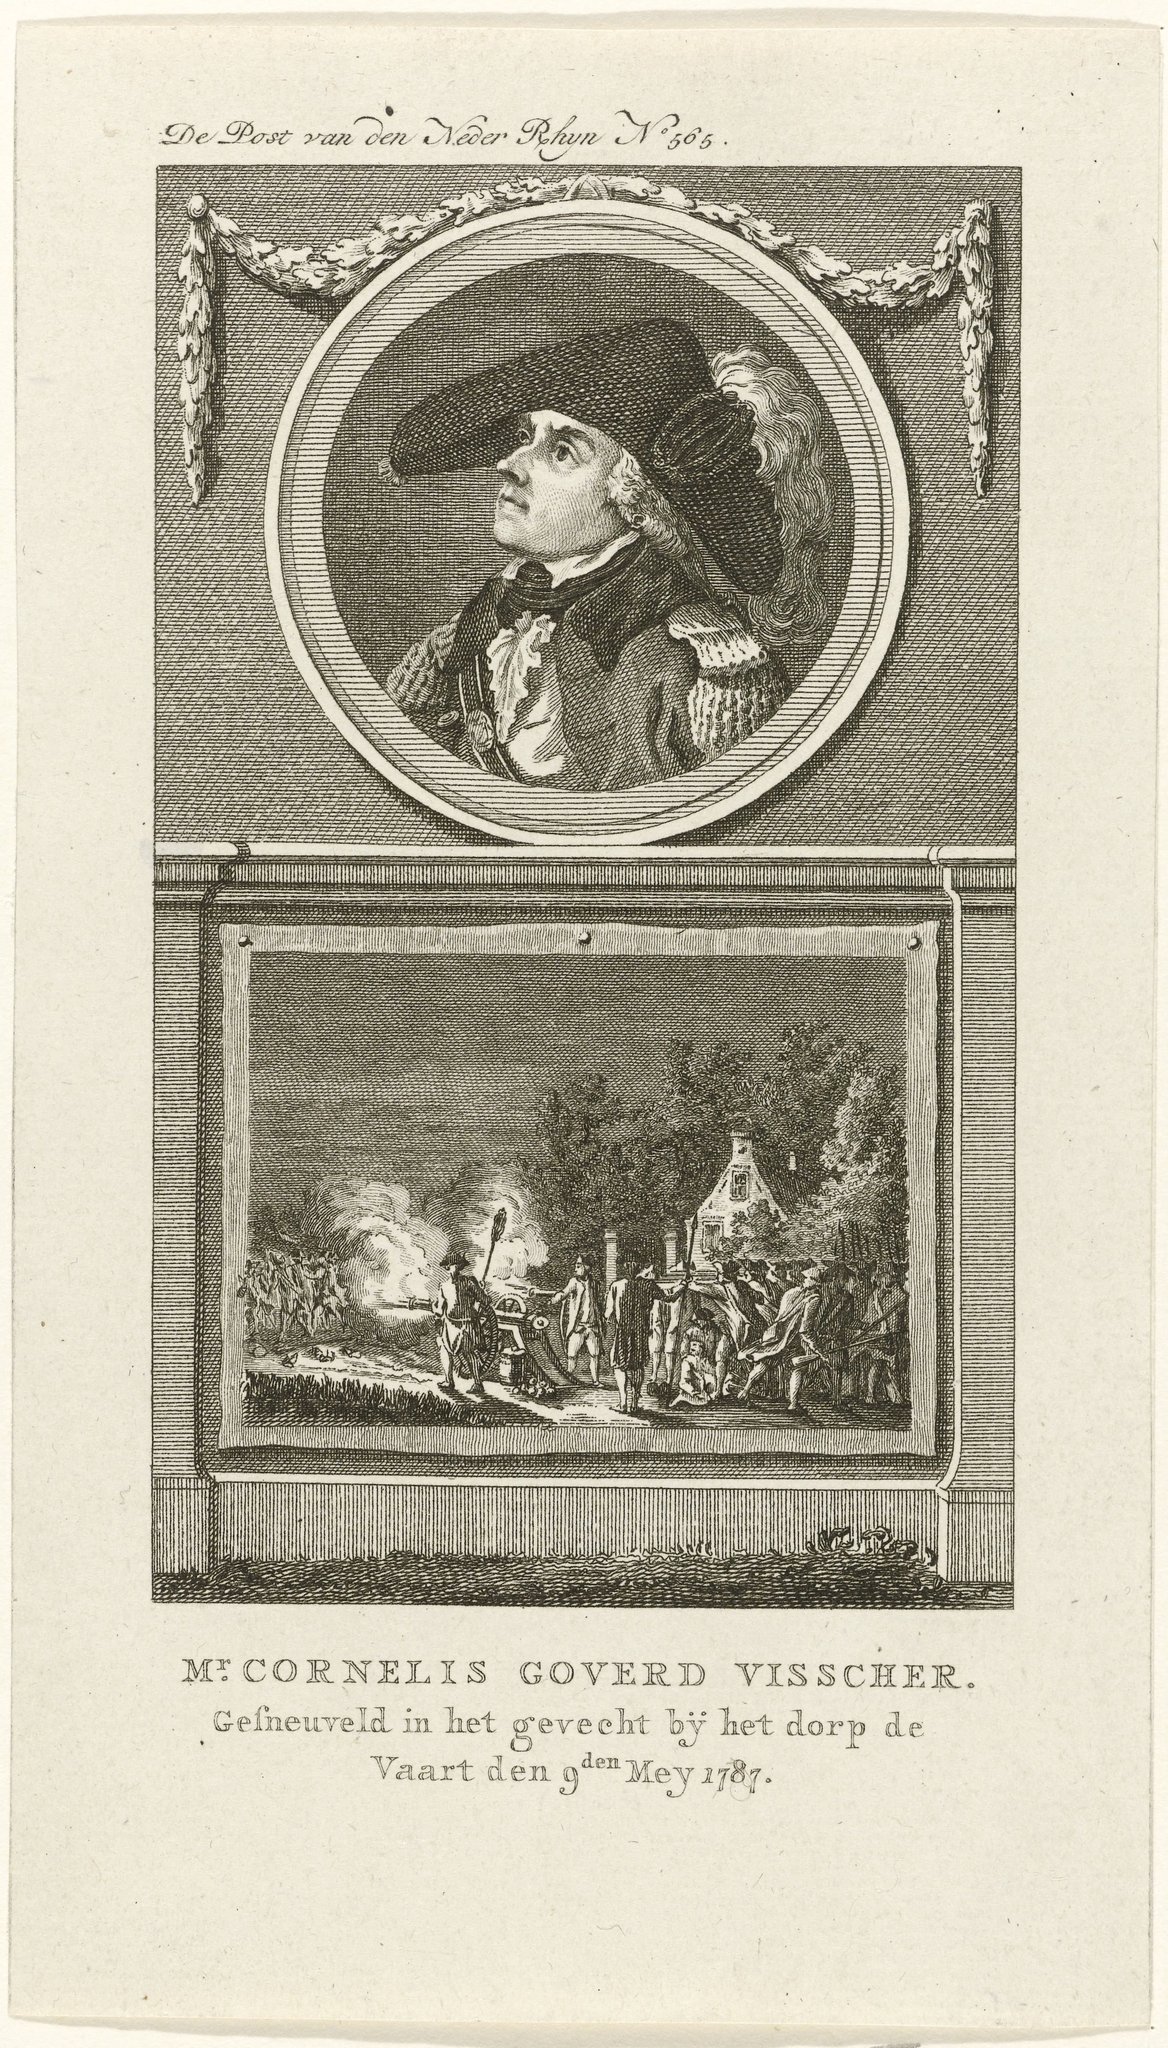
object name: print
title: Mr. Cornelis Goverd Visscher. Gesneuveld in het gevecht bij het dorp de Vaart den 9den Mey 1787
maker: Anonymous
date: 1787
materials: paper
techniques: engraving, etching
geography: northern netherlands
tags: battle (+ citizen soldiery, civil guard, citizen militia)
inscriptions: collector's mark: Lugt 2228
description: Blad met bovenaan een medaillon met het portret van Cornelis Govert Visscher, borstbeeld naar links, boven een afbeelding van het vuurgevecht waarin hij sneuvelde. Gevecht aan de vaart bij Vreeswijk buiten Utrecht tussen gewapende burgers van de Utrechtse schutterij en troepen van het regiment Van Efferen, in de avond van 9 mei 1787. Gemerkt rechtsboven: De Post van den Neder Rhyn No. 565.